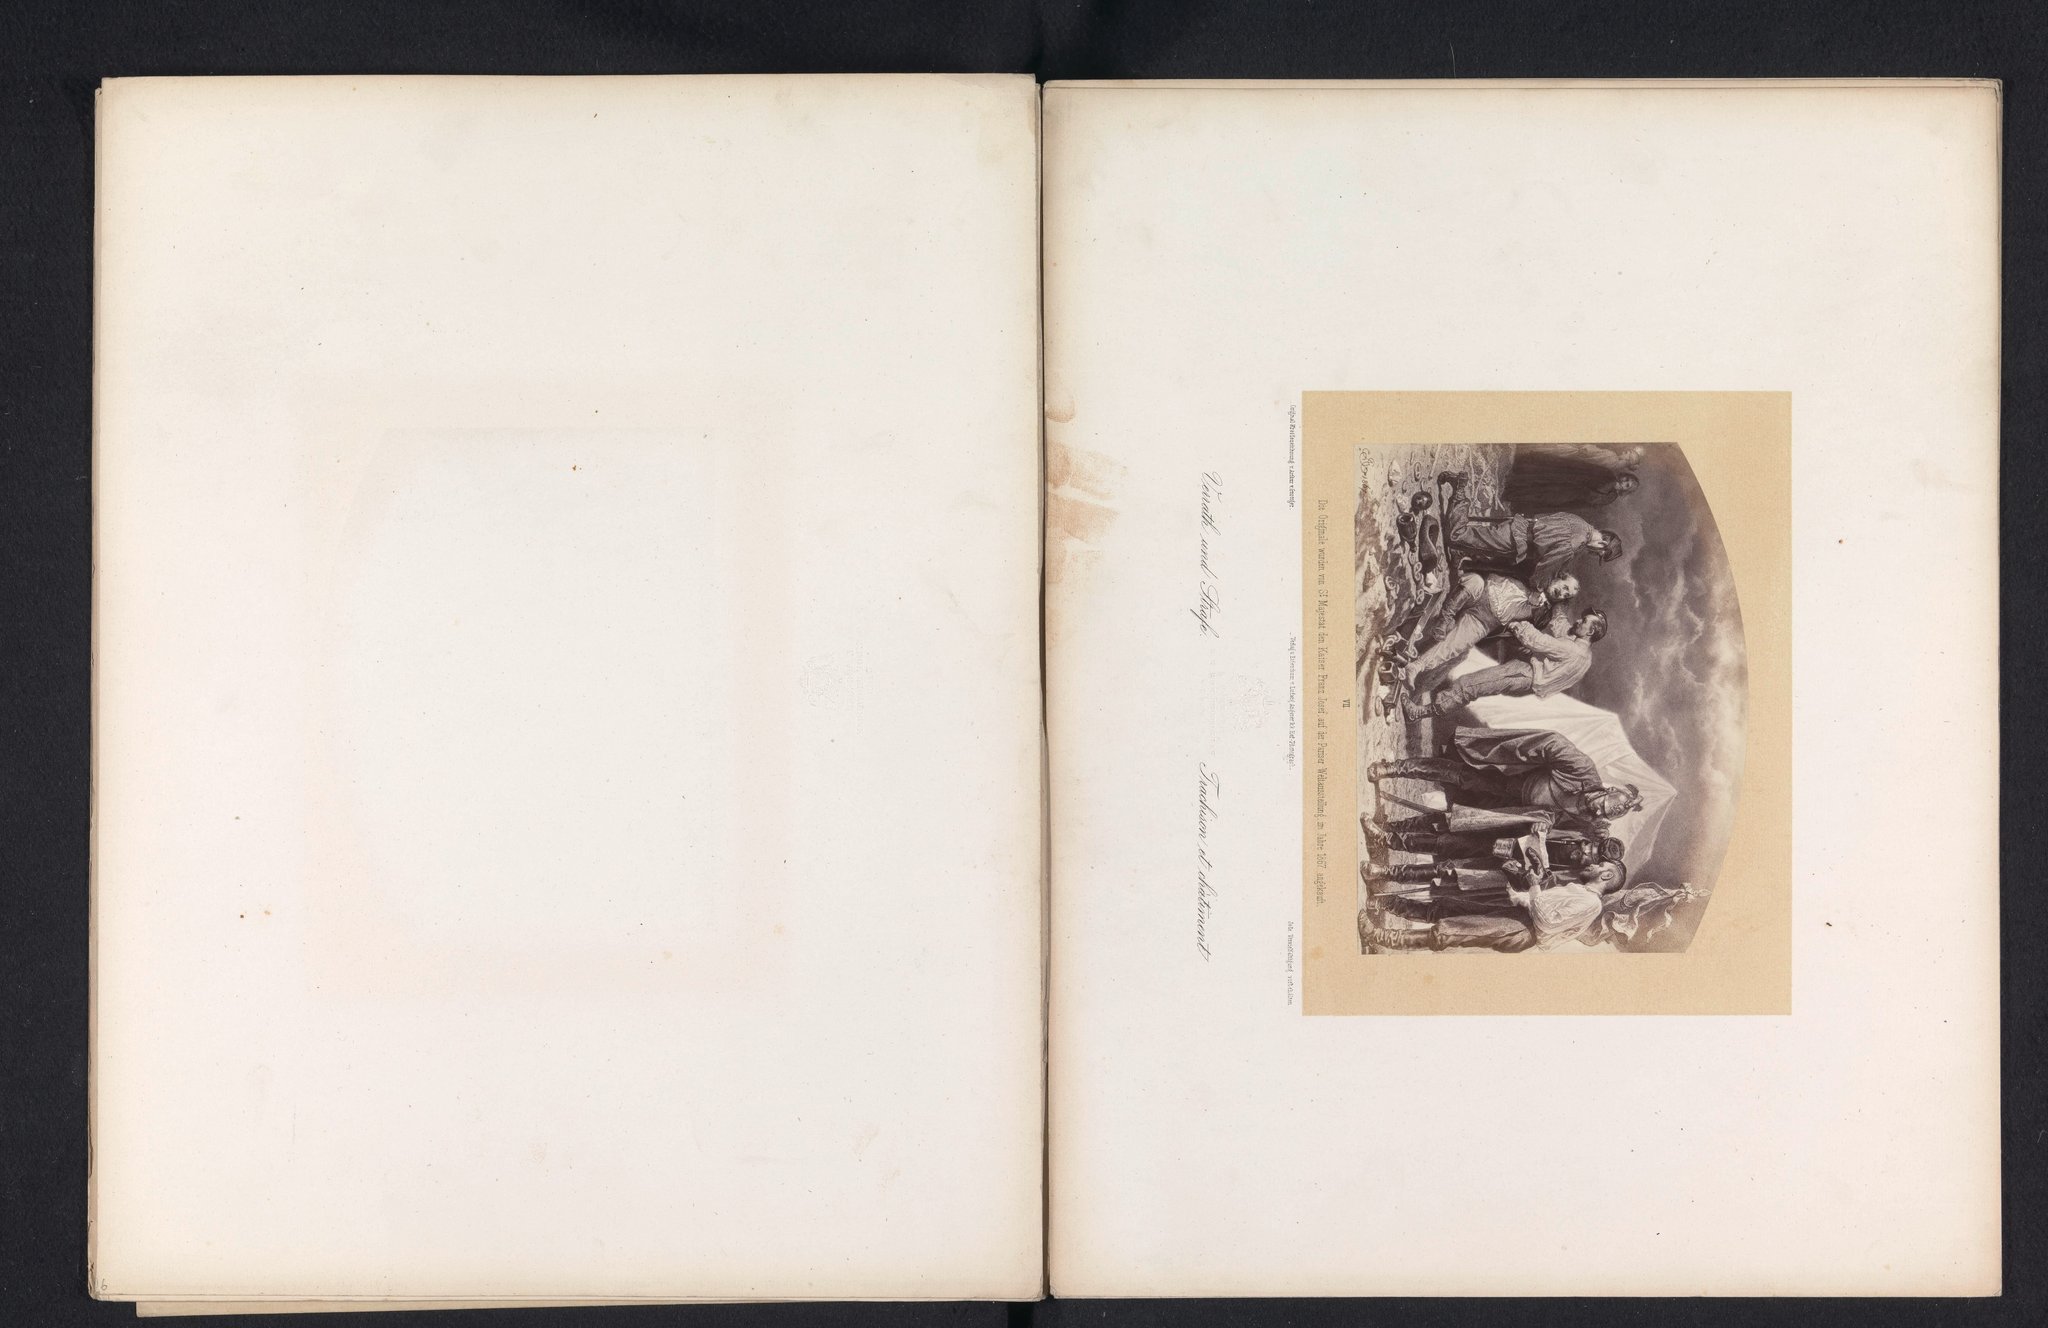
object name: reproduction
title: Verrath und Strafe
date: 1867-1868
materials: photographic support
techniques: albumen print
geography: vienna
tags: the soldier; the soldier's life, treason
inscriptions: number: ‘VII.’, inscription: ‘Die Originale wurden von Sr Majestat den Kaiser Franz Josef auf der Pariser Weltausstellung im Jahre 1867 angekauft.’